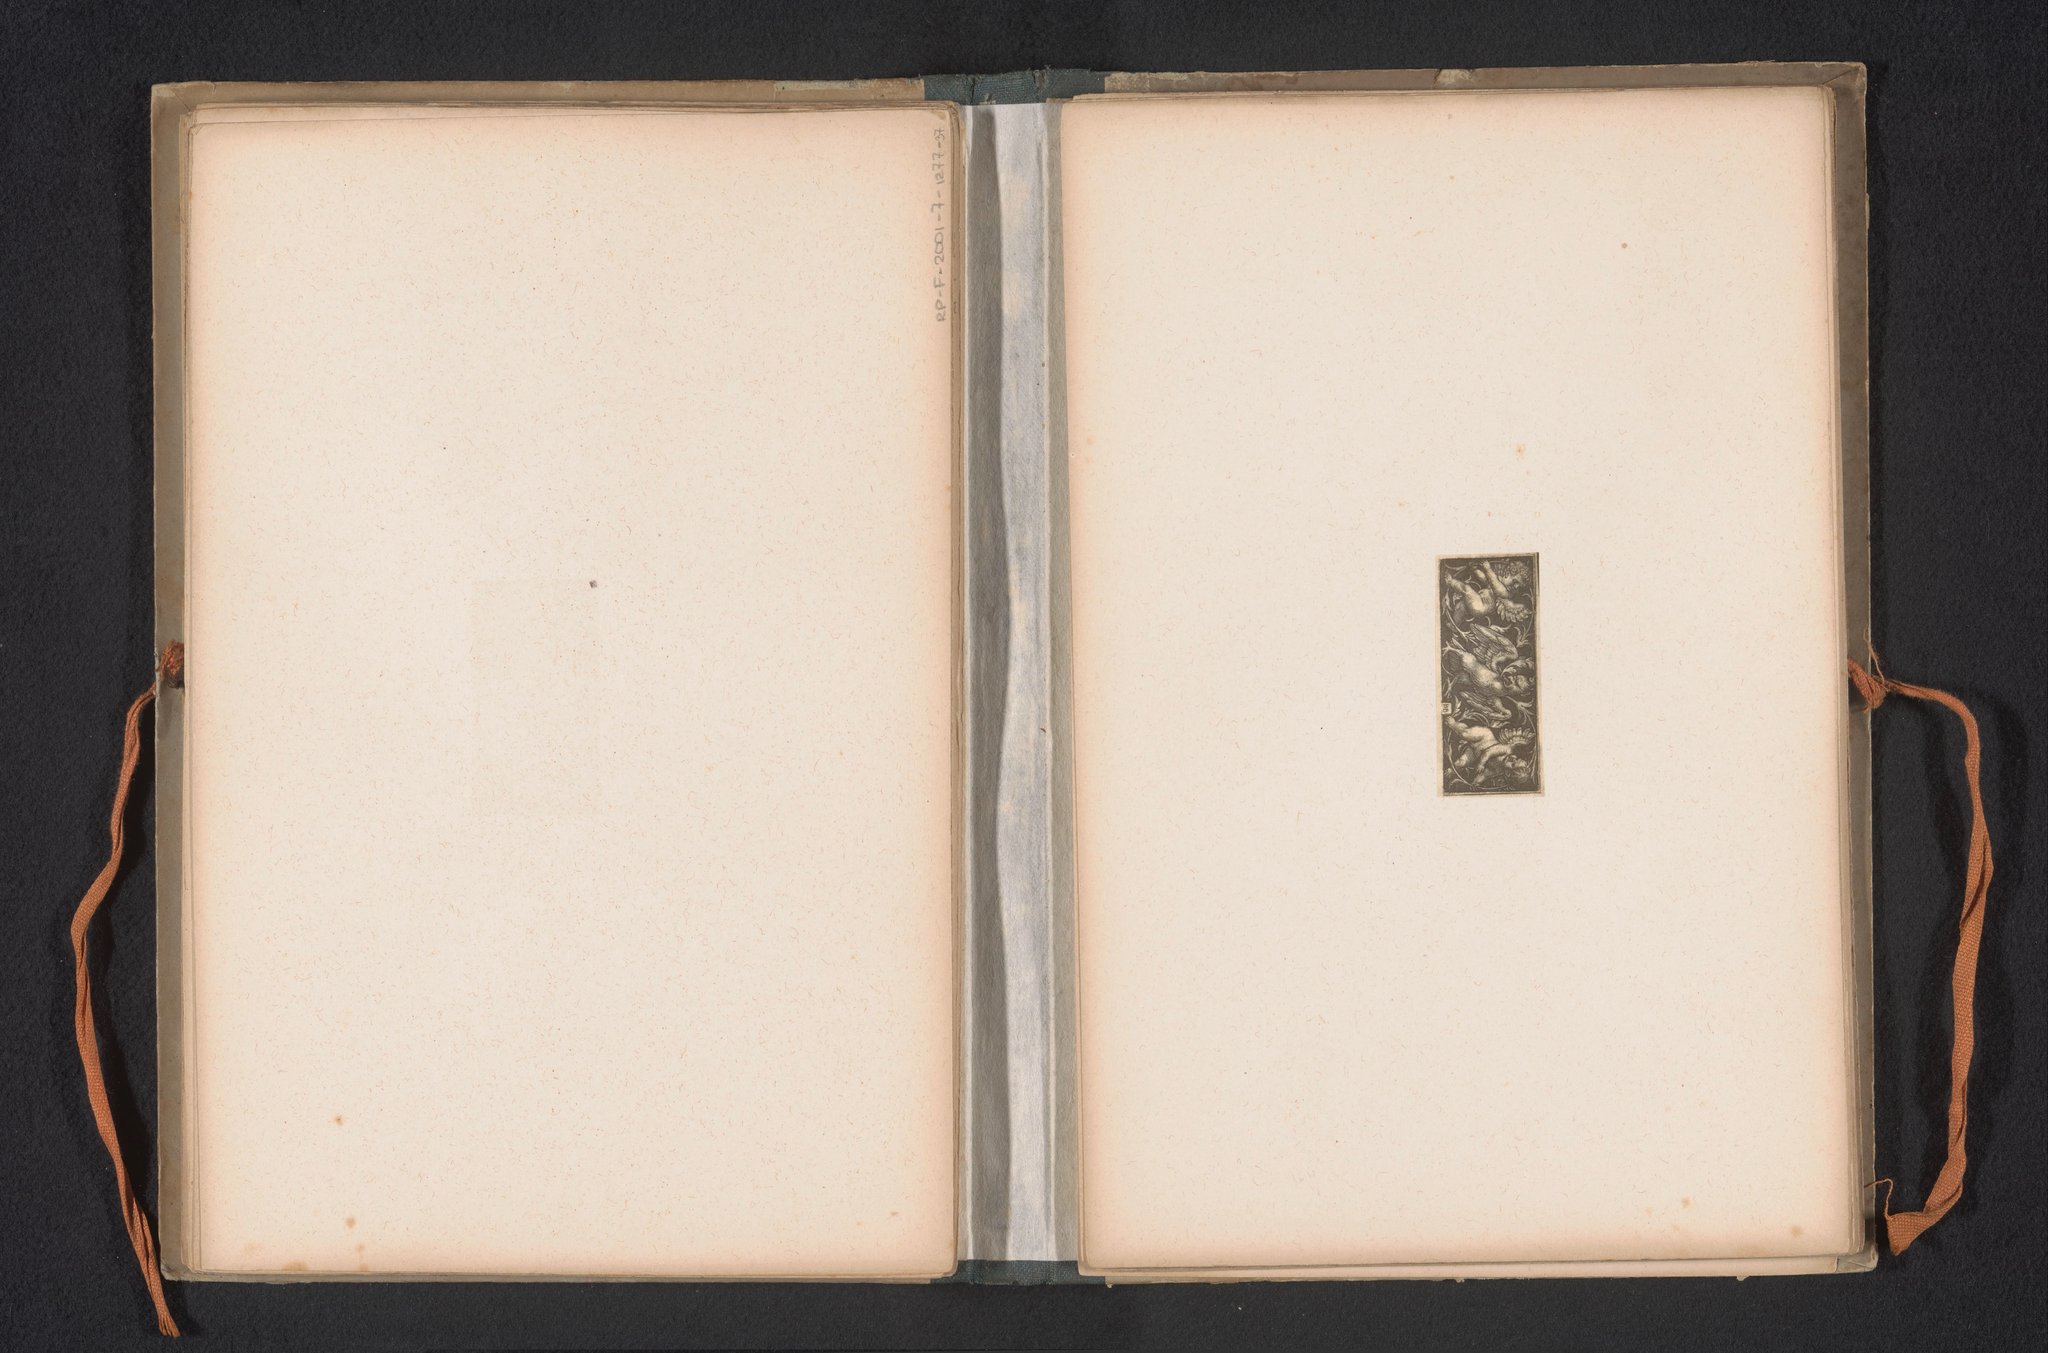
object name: photomechanical print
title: Reproductie van een prent van groteske ornamenten met twee cupido's door Hans Sebald Beham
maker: hans sebald beham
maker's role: designer, draughtsman, print maker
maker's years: 1500-1550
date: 1866-1871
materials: paper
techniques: woodburytype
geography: brussels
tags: ornament ~ grotesque, cupids: 'amores', 'amoretti', 'putti'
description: Deze prent maakt deel uit van een omslag met 57 prenten op 54 bladen.